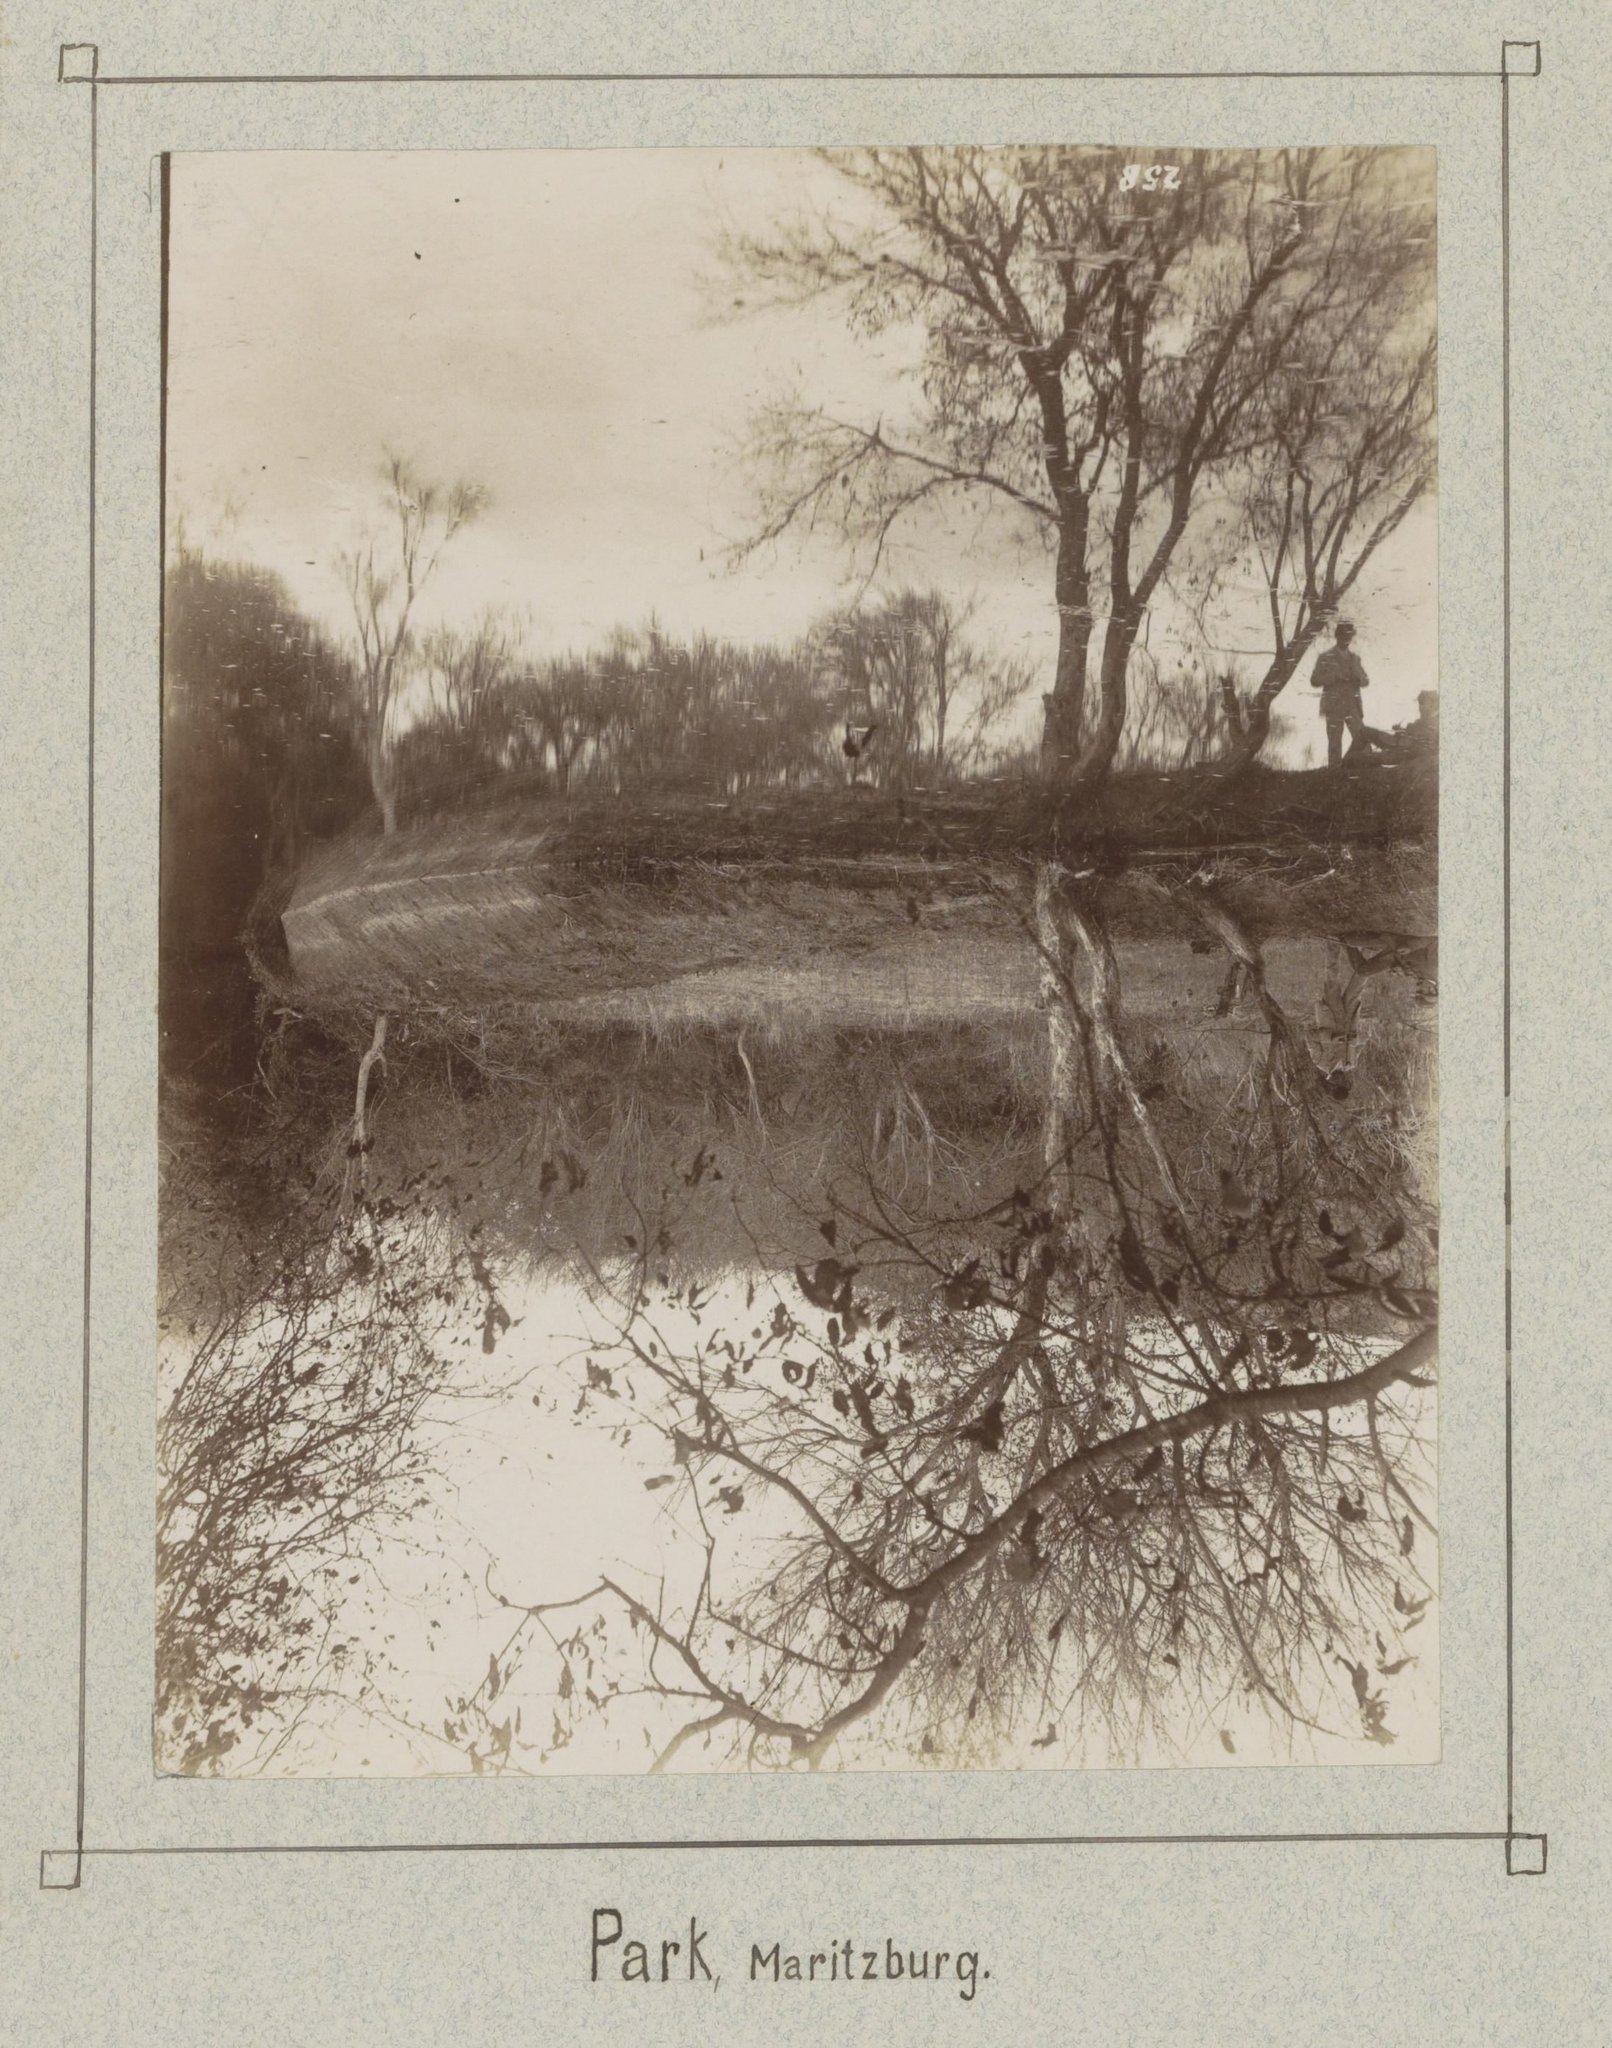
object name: photograph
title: Park, Maritzburg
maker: Anonymous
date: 1880-1900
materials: photographic support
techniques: albumen print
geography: pietermaritzburg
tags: public gardens, park (+ city(-scape) with figures, staffage)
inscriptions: number: ‘258’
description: Foto is ondersteboven ingeplakt in album. Onderdeel van Reisalbum met foto's van Zuid-Afrika, Madeira, Portugal, Frankrijk en Duitsland.